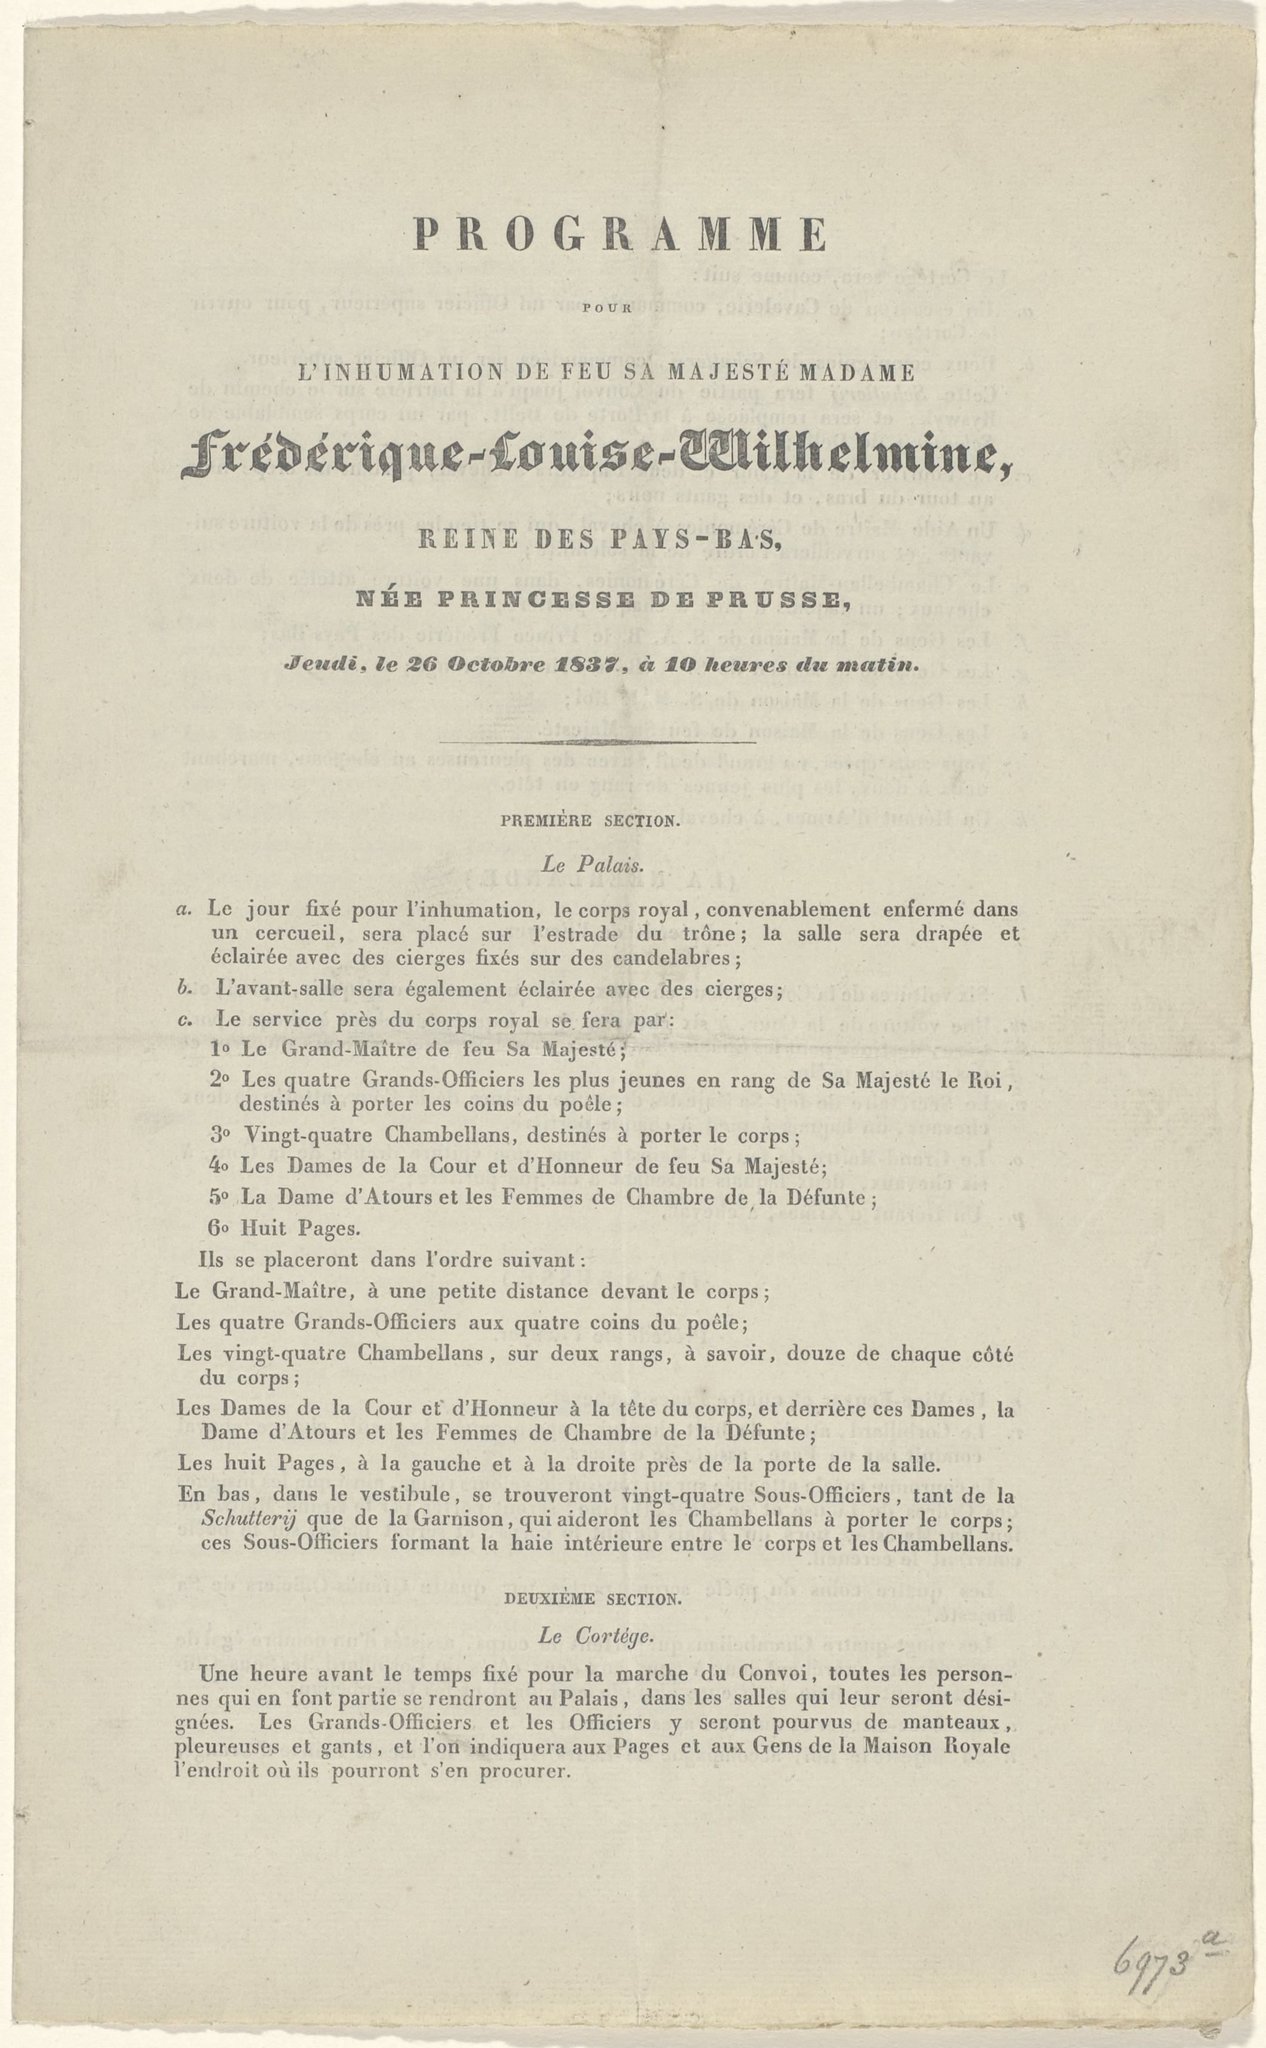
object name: text sheet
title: Programme pour l'inhumation de feu sa majesté madame Frédérique-Louise-Wilhelmine (...) Jeudi, le 26 Octobre 1837, à 10 heures du matin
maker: adrianus david schinkel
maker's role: printer, publisher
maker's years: 1784-1864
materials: paper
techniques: letterpress printing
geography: the hague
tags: berlin, the hague, wilhelmina frederica louisa (koningin der nederlanden)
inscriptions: collector's mark: Lugt 2228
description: Programma van de begrafenis van koningin Wilhelmina van Pruisen op 26 oktober 1837. Dubbelgevouwen blad bedrukt op alle zijden met het programma van de begrafenis.